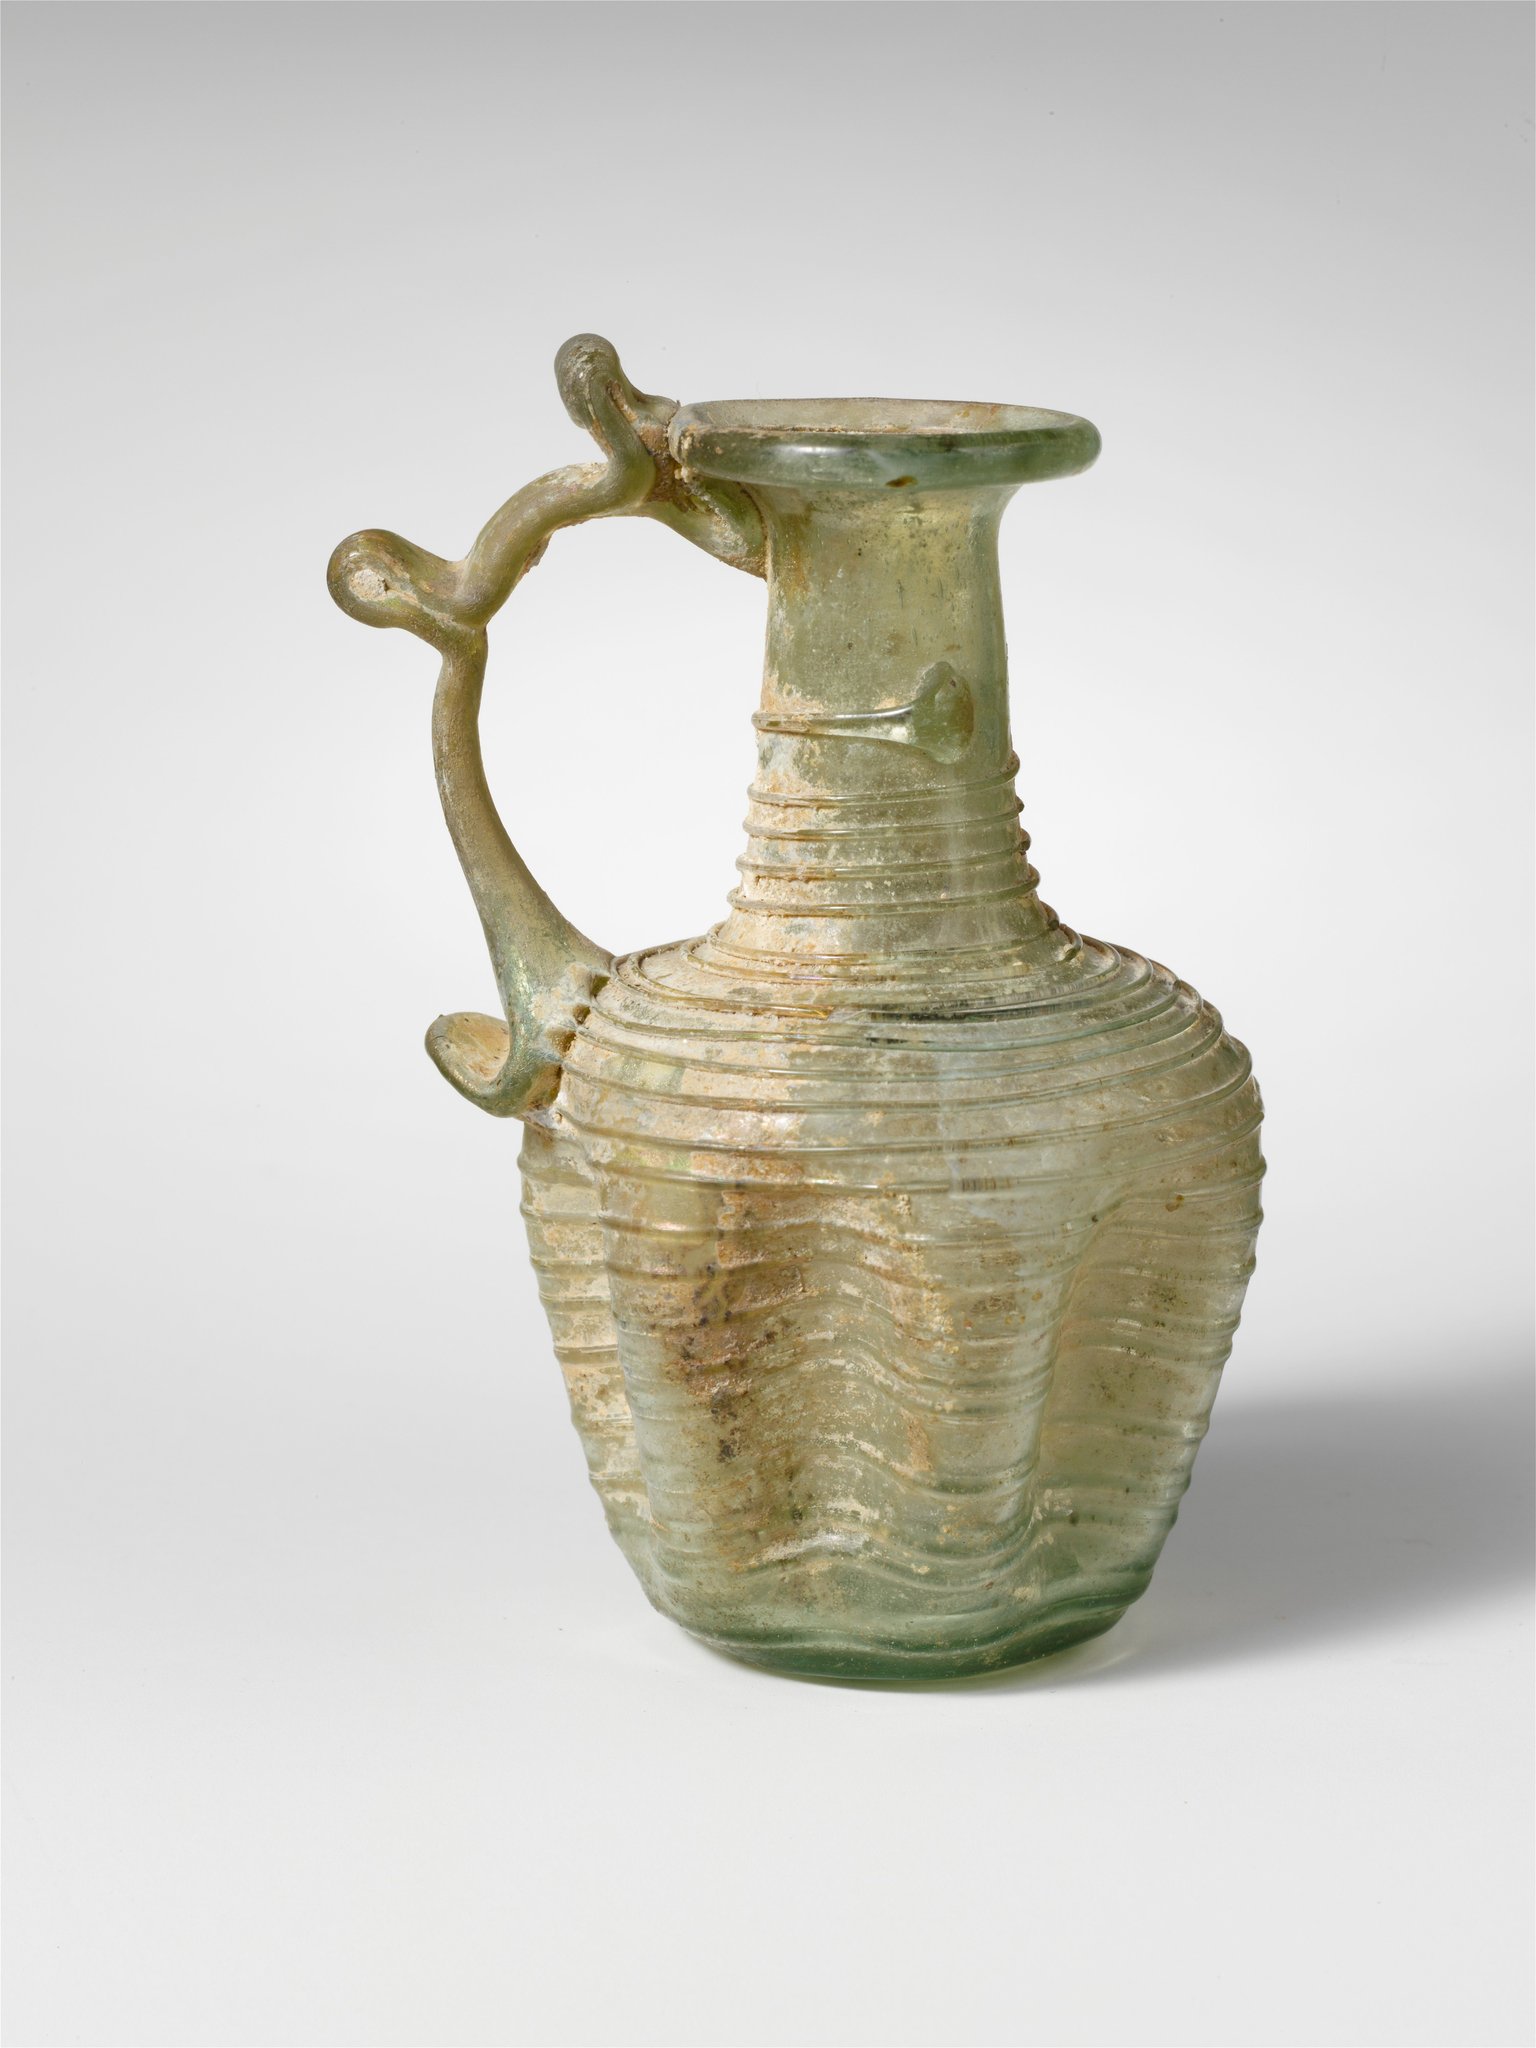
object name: jug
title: Glass jug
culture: roman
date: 201-400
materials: glass